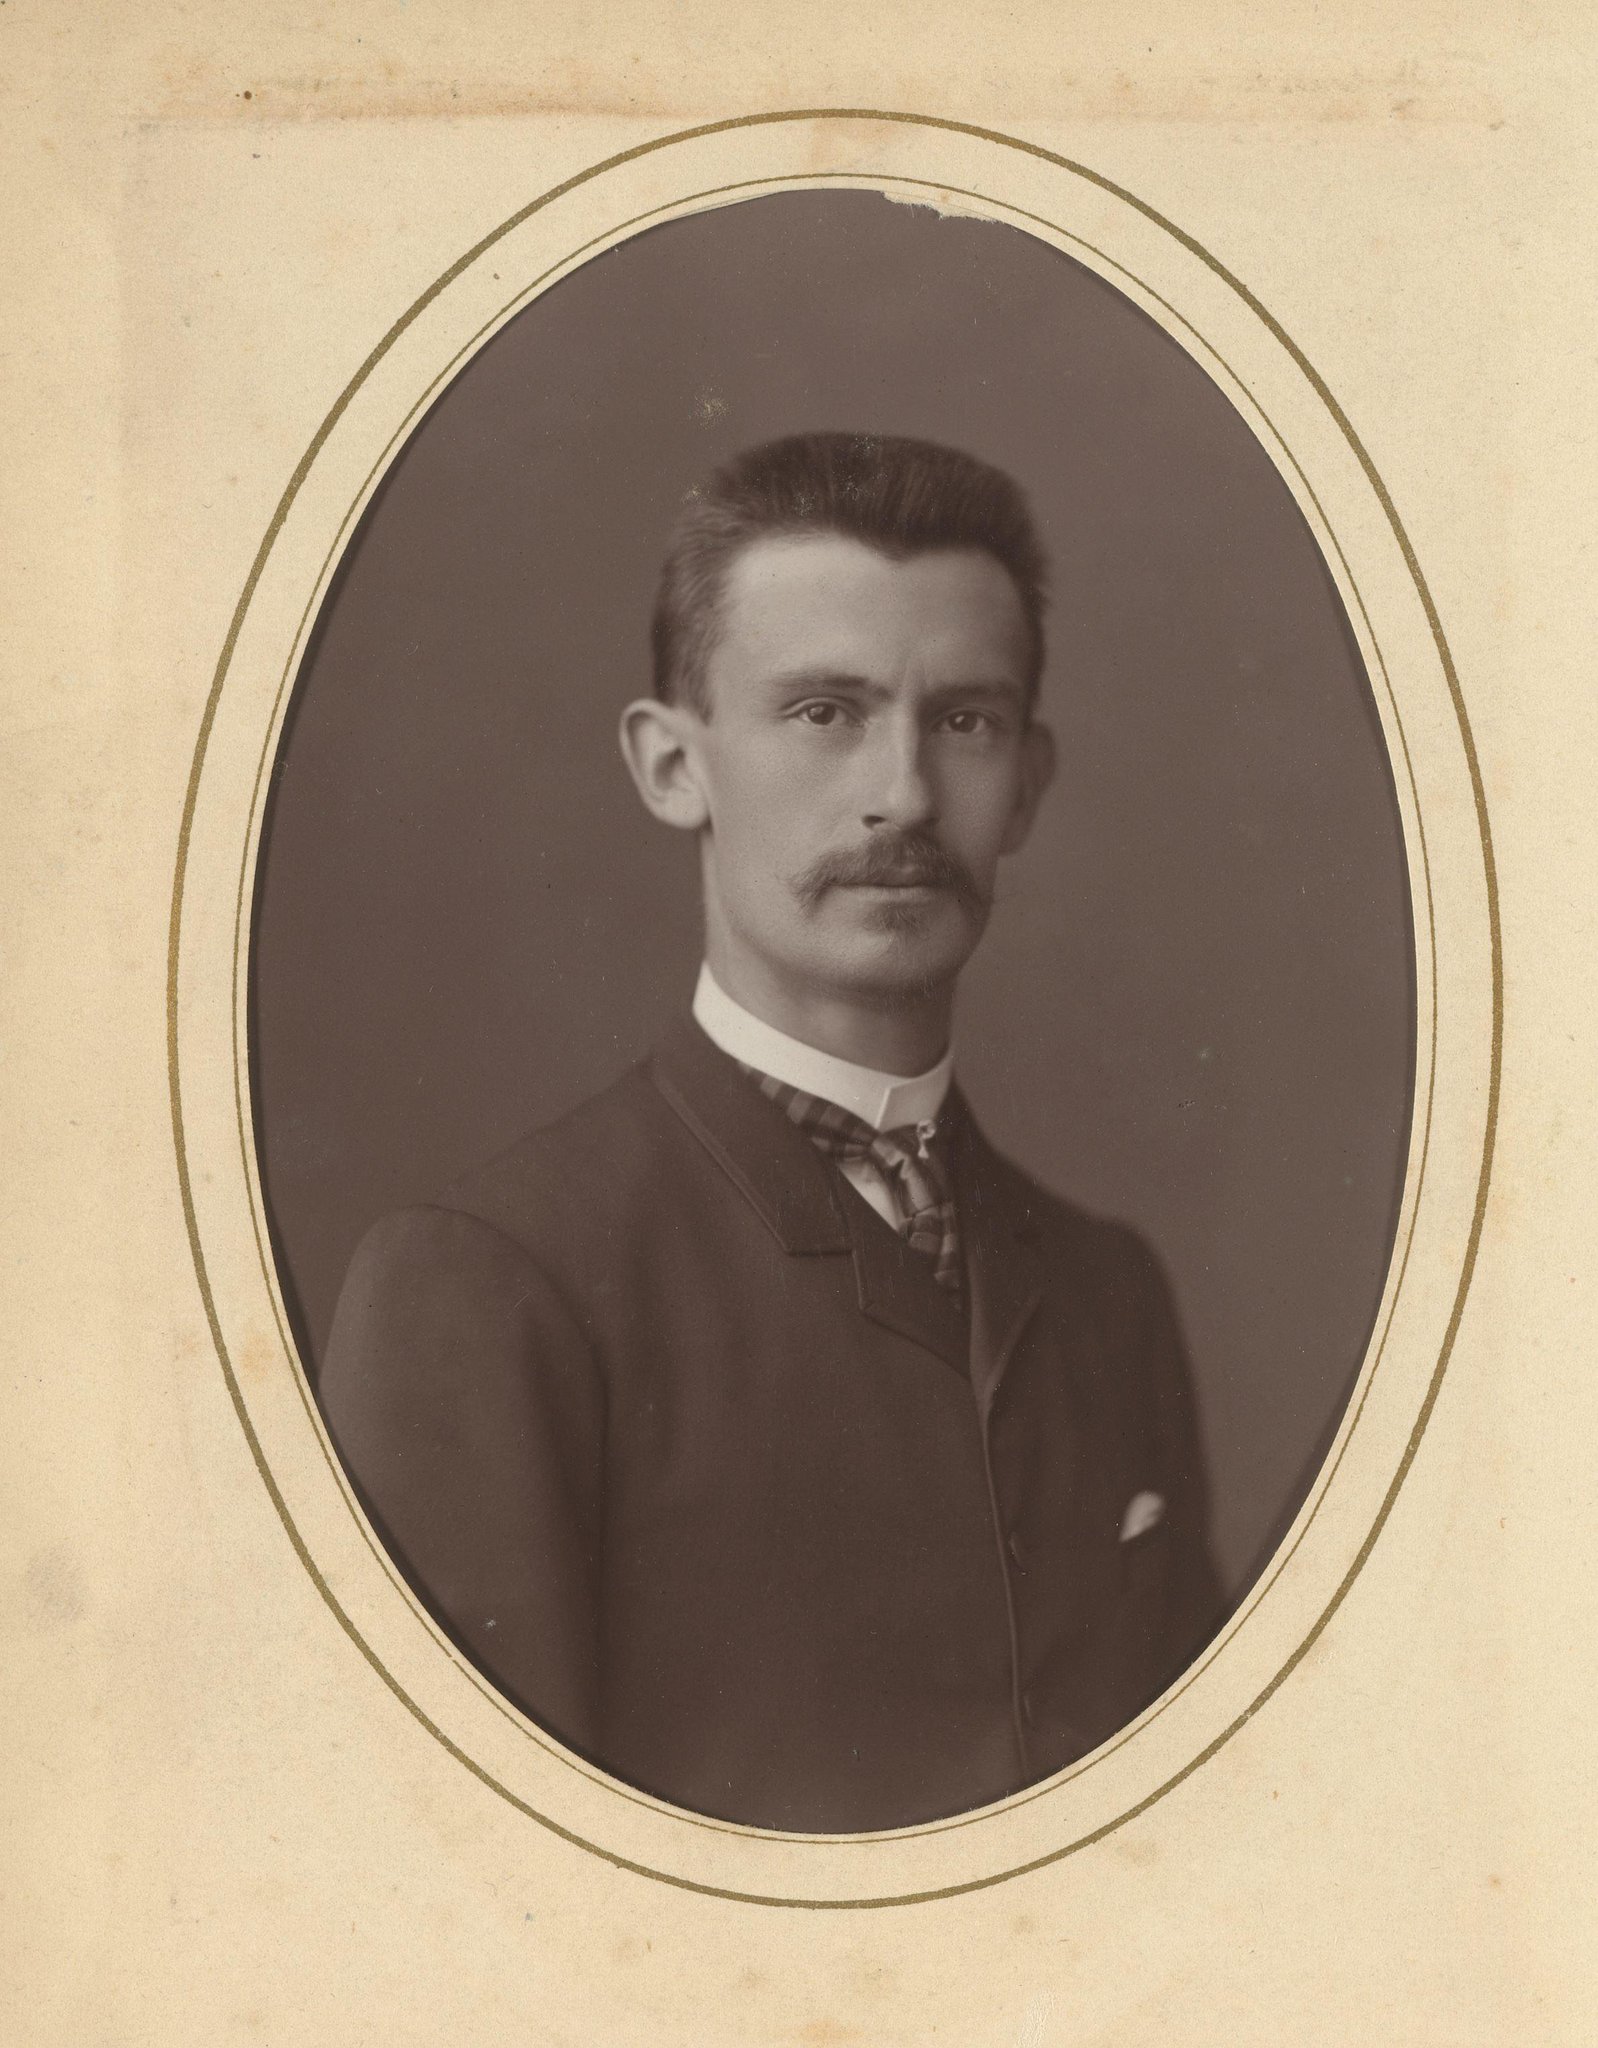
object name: album leaf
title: Portret van een man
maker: paul joseph nicolas nestor schaffers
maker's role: fotograaf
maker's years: 1826-1896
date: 1875-1896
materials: cardboard, photographic support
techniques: carbon print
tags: moustache, adult man, historical persons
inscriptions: inscription: ‘Impression inalterable charbon’, inscription: ‘Procedé Inaltérable/ Photographie au Charbon/ Nestor Schaffers/ Photographe/ Rue Guinard 9/ Gand’